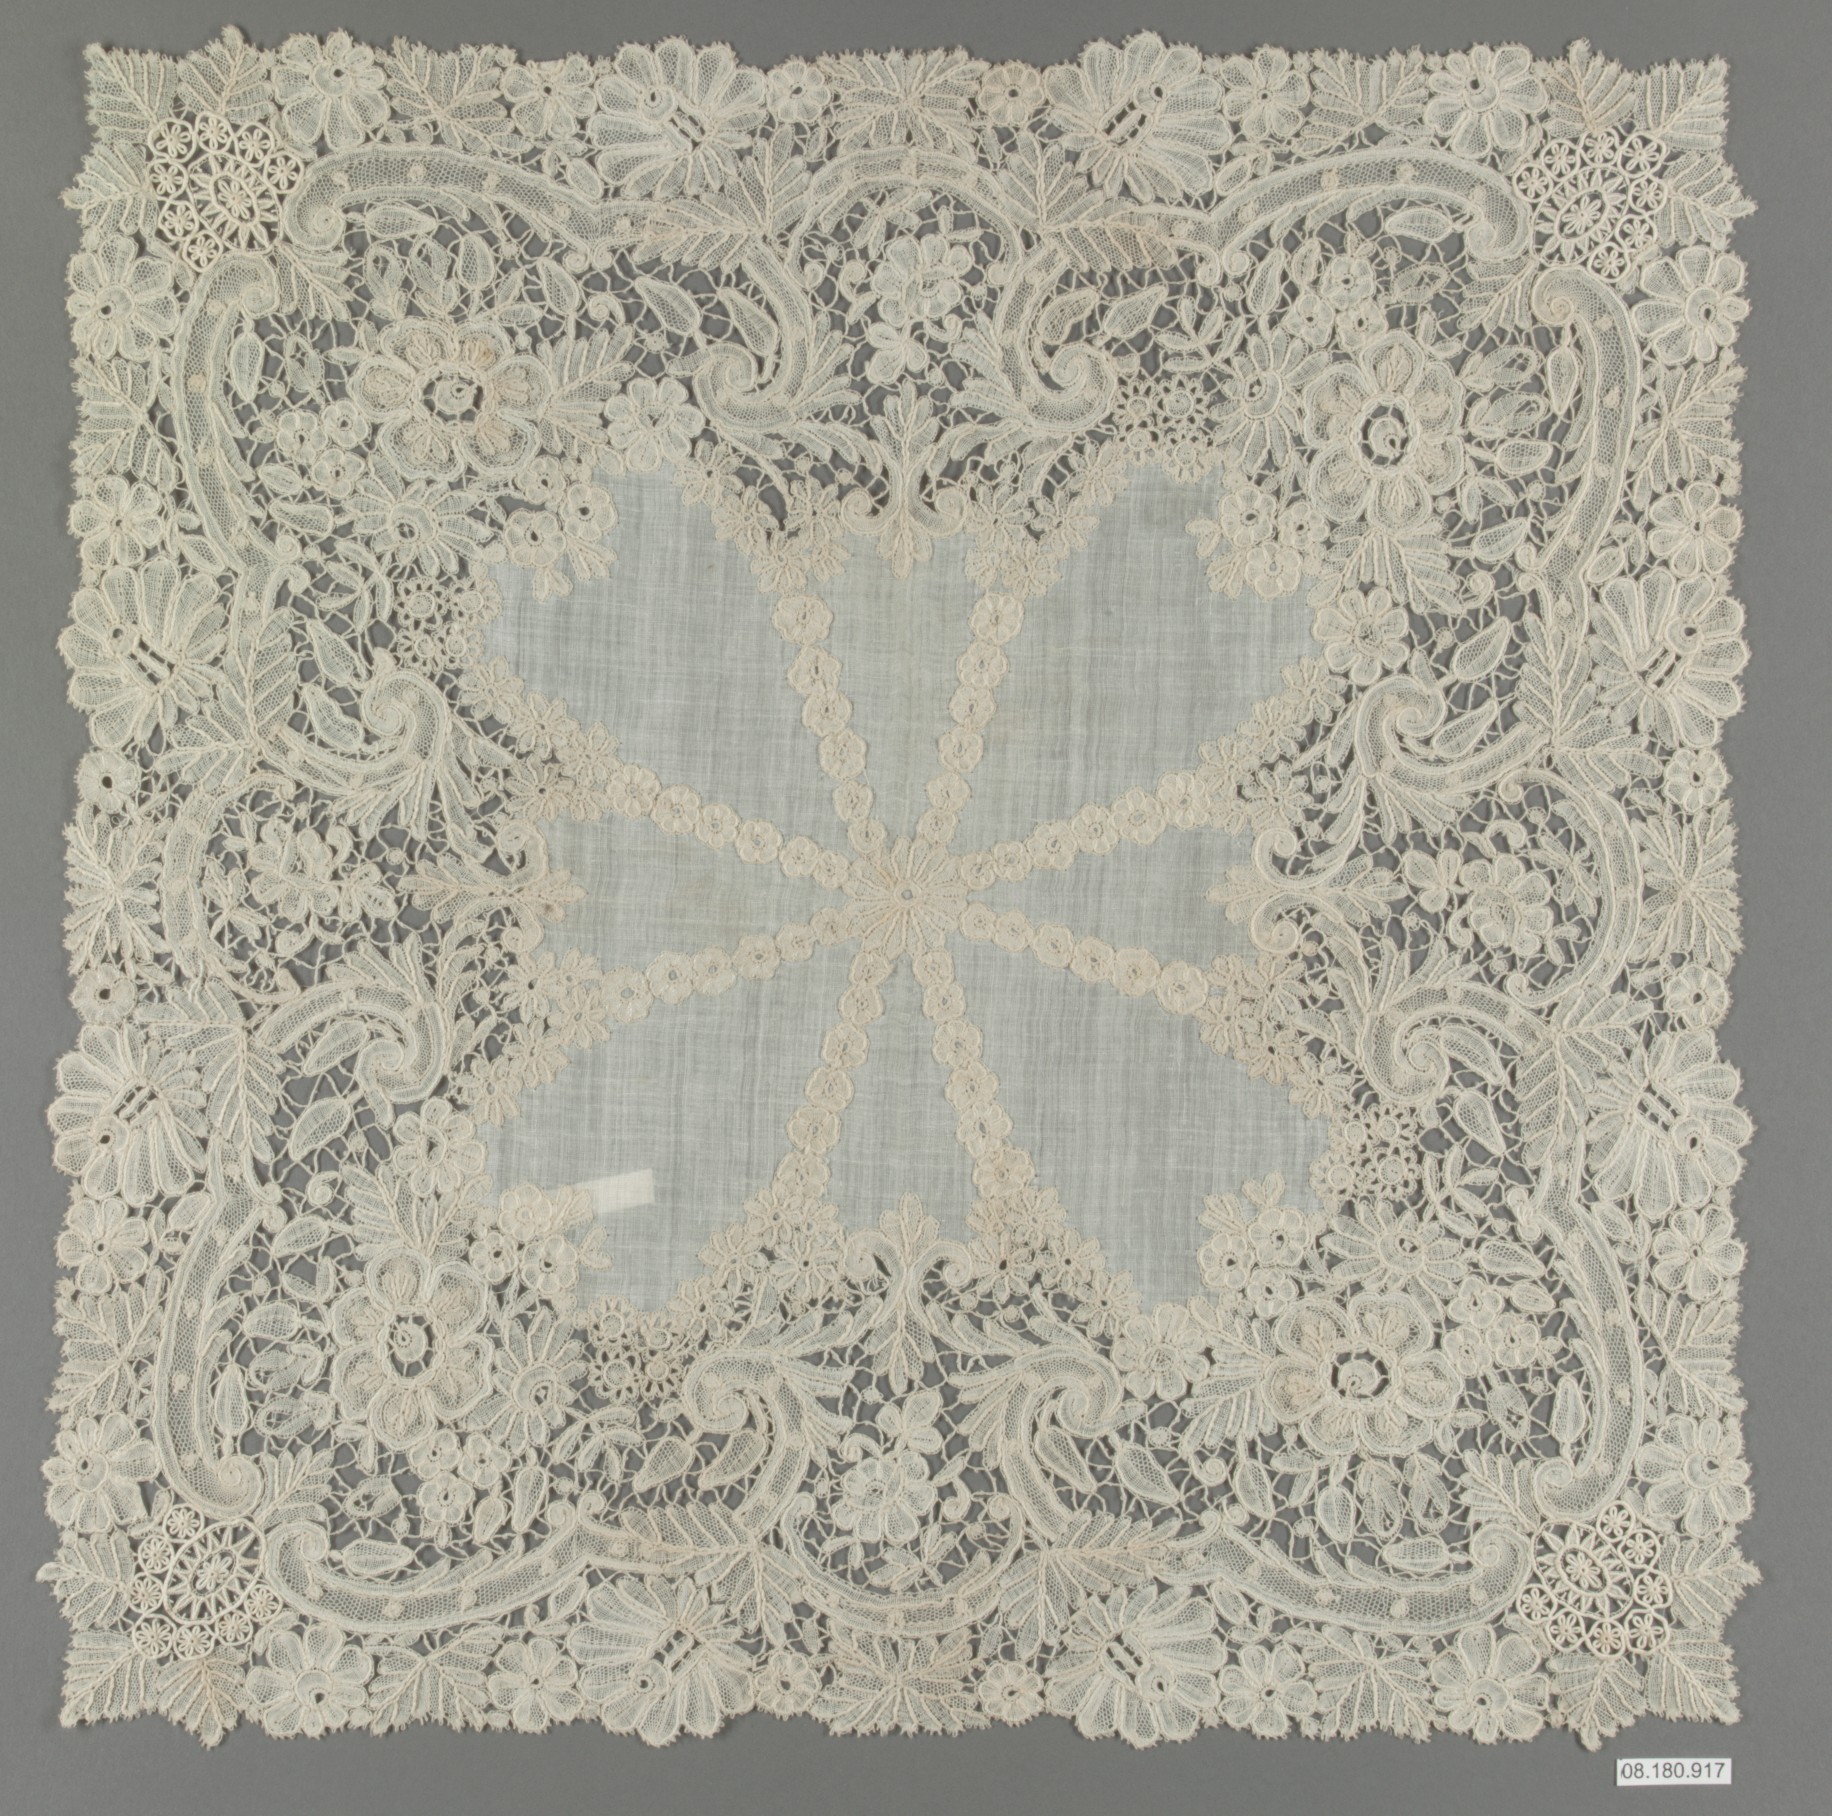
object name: handkerchief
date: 1801-1900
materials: lace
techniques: lace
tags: flowers